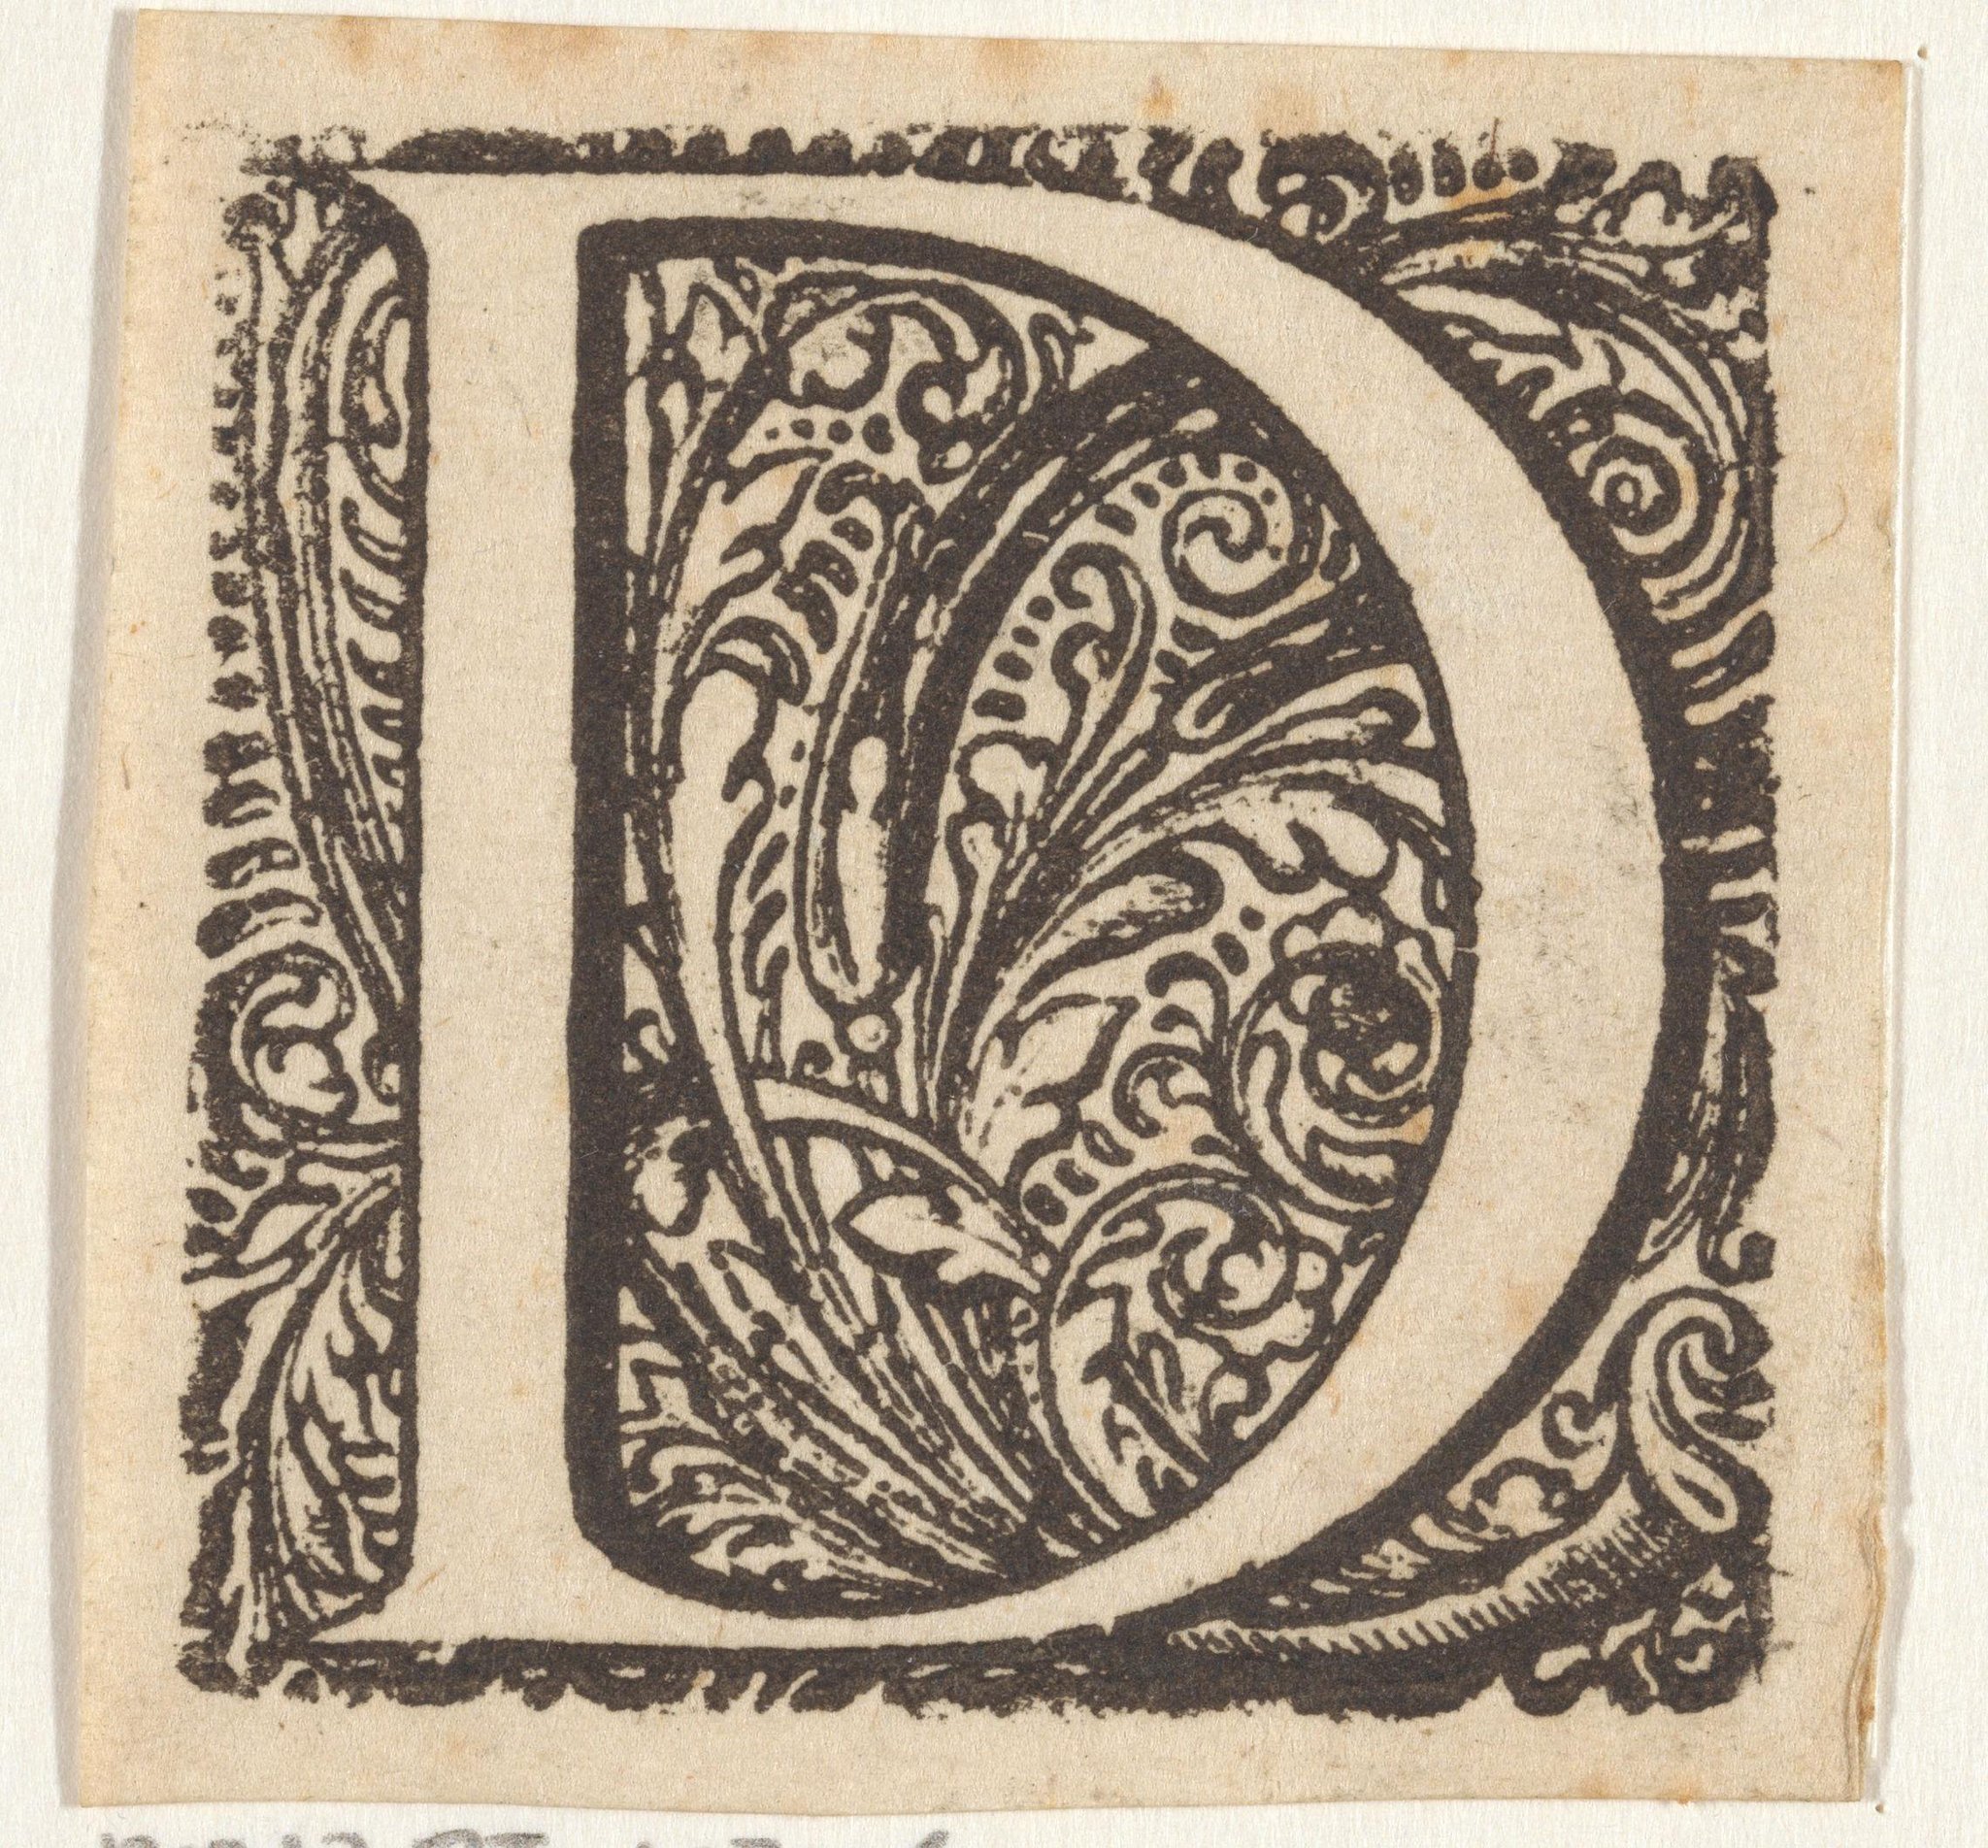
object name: print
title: Letter D in een geornamenteerde omlijsting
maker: Anonymous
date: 1600-1699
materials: paper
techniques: woodcut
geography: netherlands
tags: fancy letters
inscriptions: collector's mark: Lugt 240